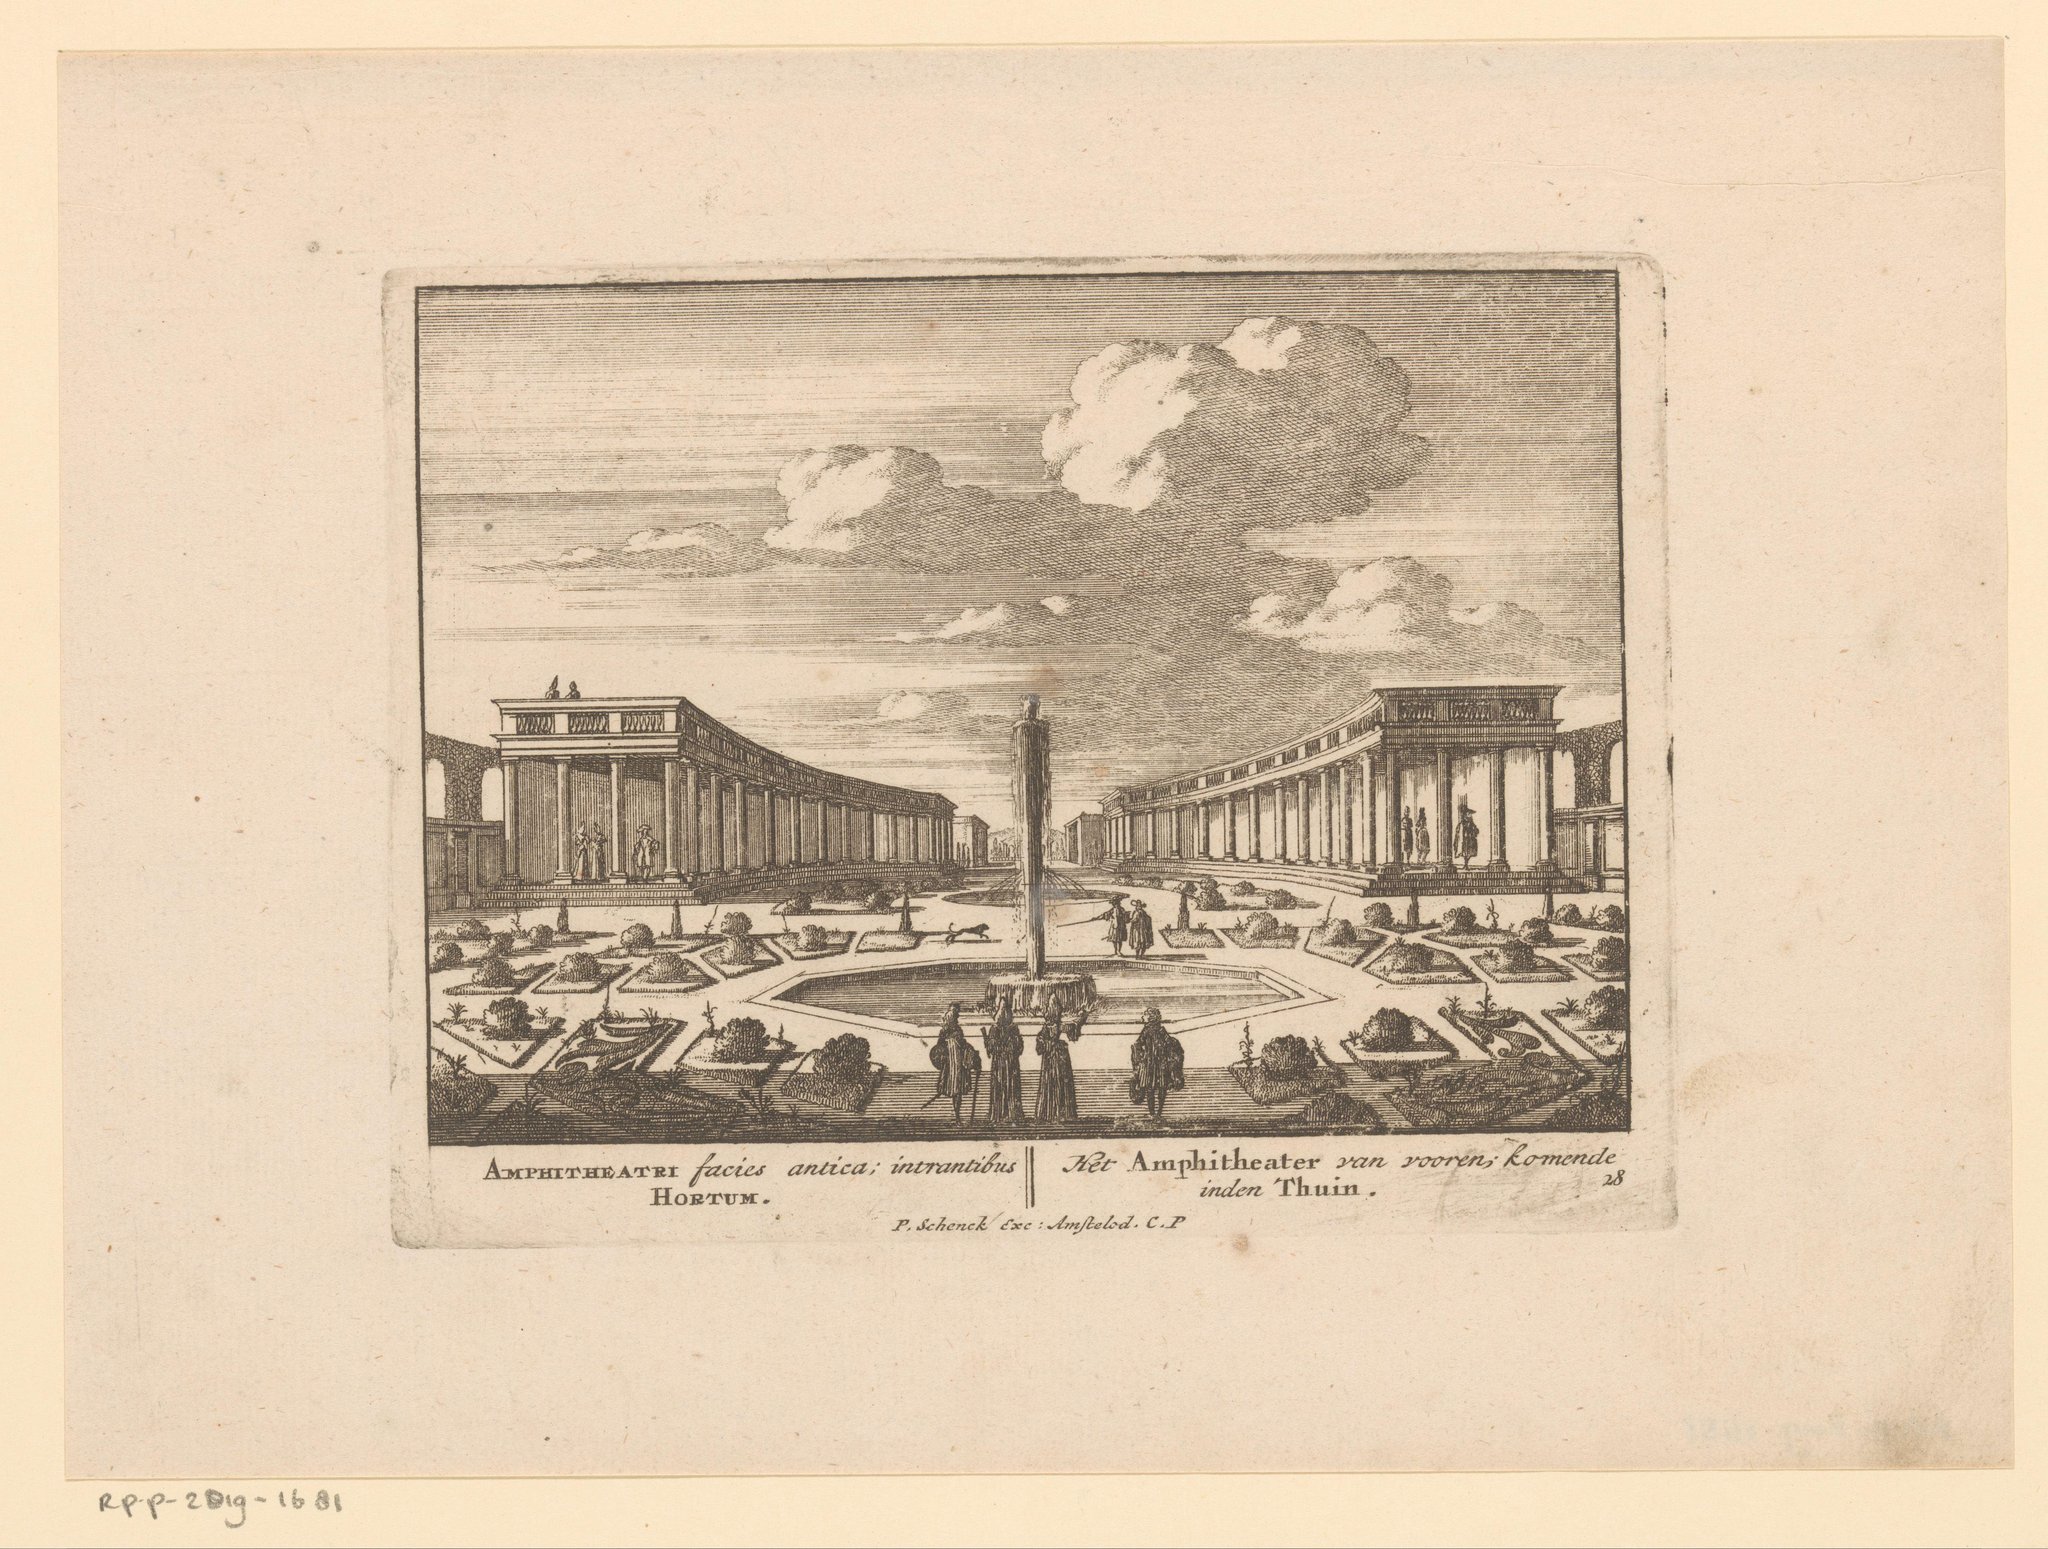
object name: print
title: Viervoudig schouwspel van wonderen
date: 1700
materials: paper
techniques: etching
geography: amsterdam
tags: garden, amphitheatre, palace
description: Andere staat ook gebruikt in: Call, Jan van. Admirandorum Quadruplex Spectaculum. Amsterdam: Pieter Schenk (I), [1700].* * De titelprent, opdracht en het portret van Frederik van Saksen zijn gegraveerd door Pieter Schenk (I). De overige prenten uit deze serie zijn, zoals aangegeven op de titelprent, van de hand van Jan van Call (I).